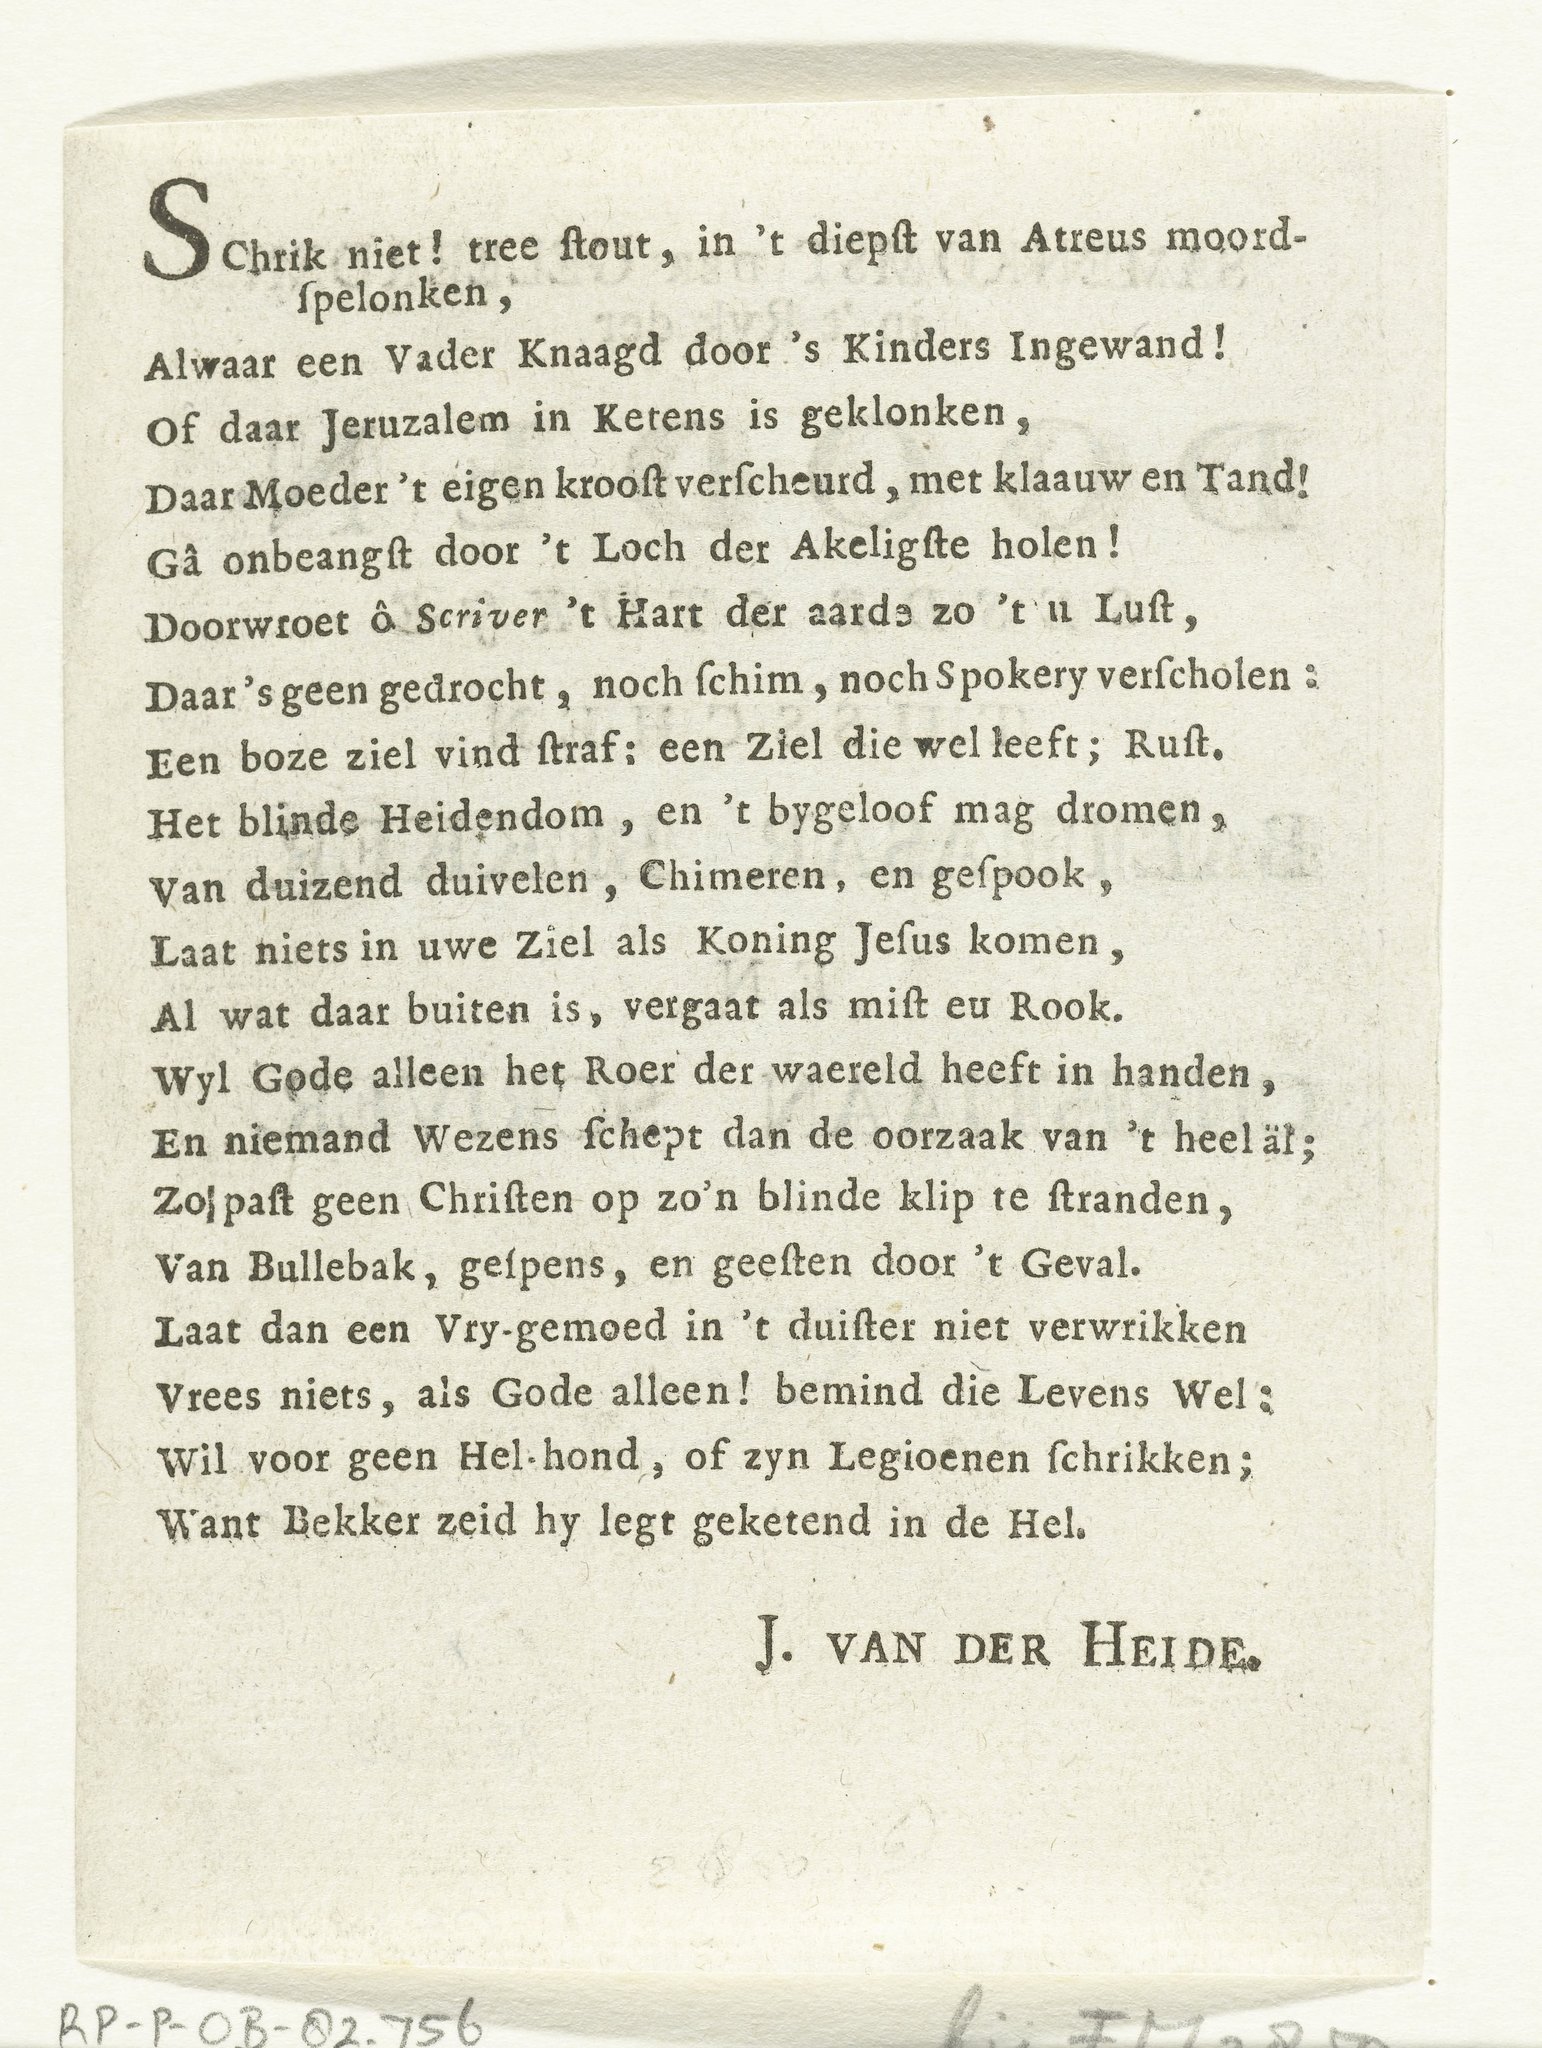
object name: text sheet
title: Vers op de samenkomst van Christiaan Scriver en Balthasar Bekker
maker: jan van der heide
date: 1739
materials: paper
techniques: letterpress printing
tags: balthasar bekker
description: Vers op de ontmoeting in het dodenrijk tussen de geleerden Christiaan Scriver en Balthasar Bekker. Tekstblad met titelpagina en vers op beide zijden. Onderdeel van een groep bladen in verband met de uitgave in 1691 van het boek: De betoverde weereld, van Balthasar Bekker.